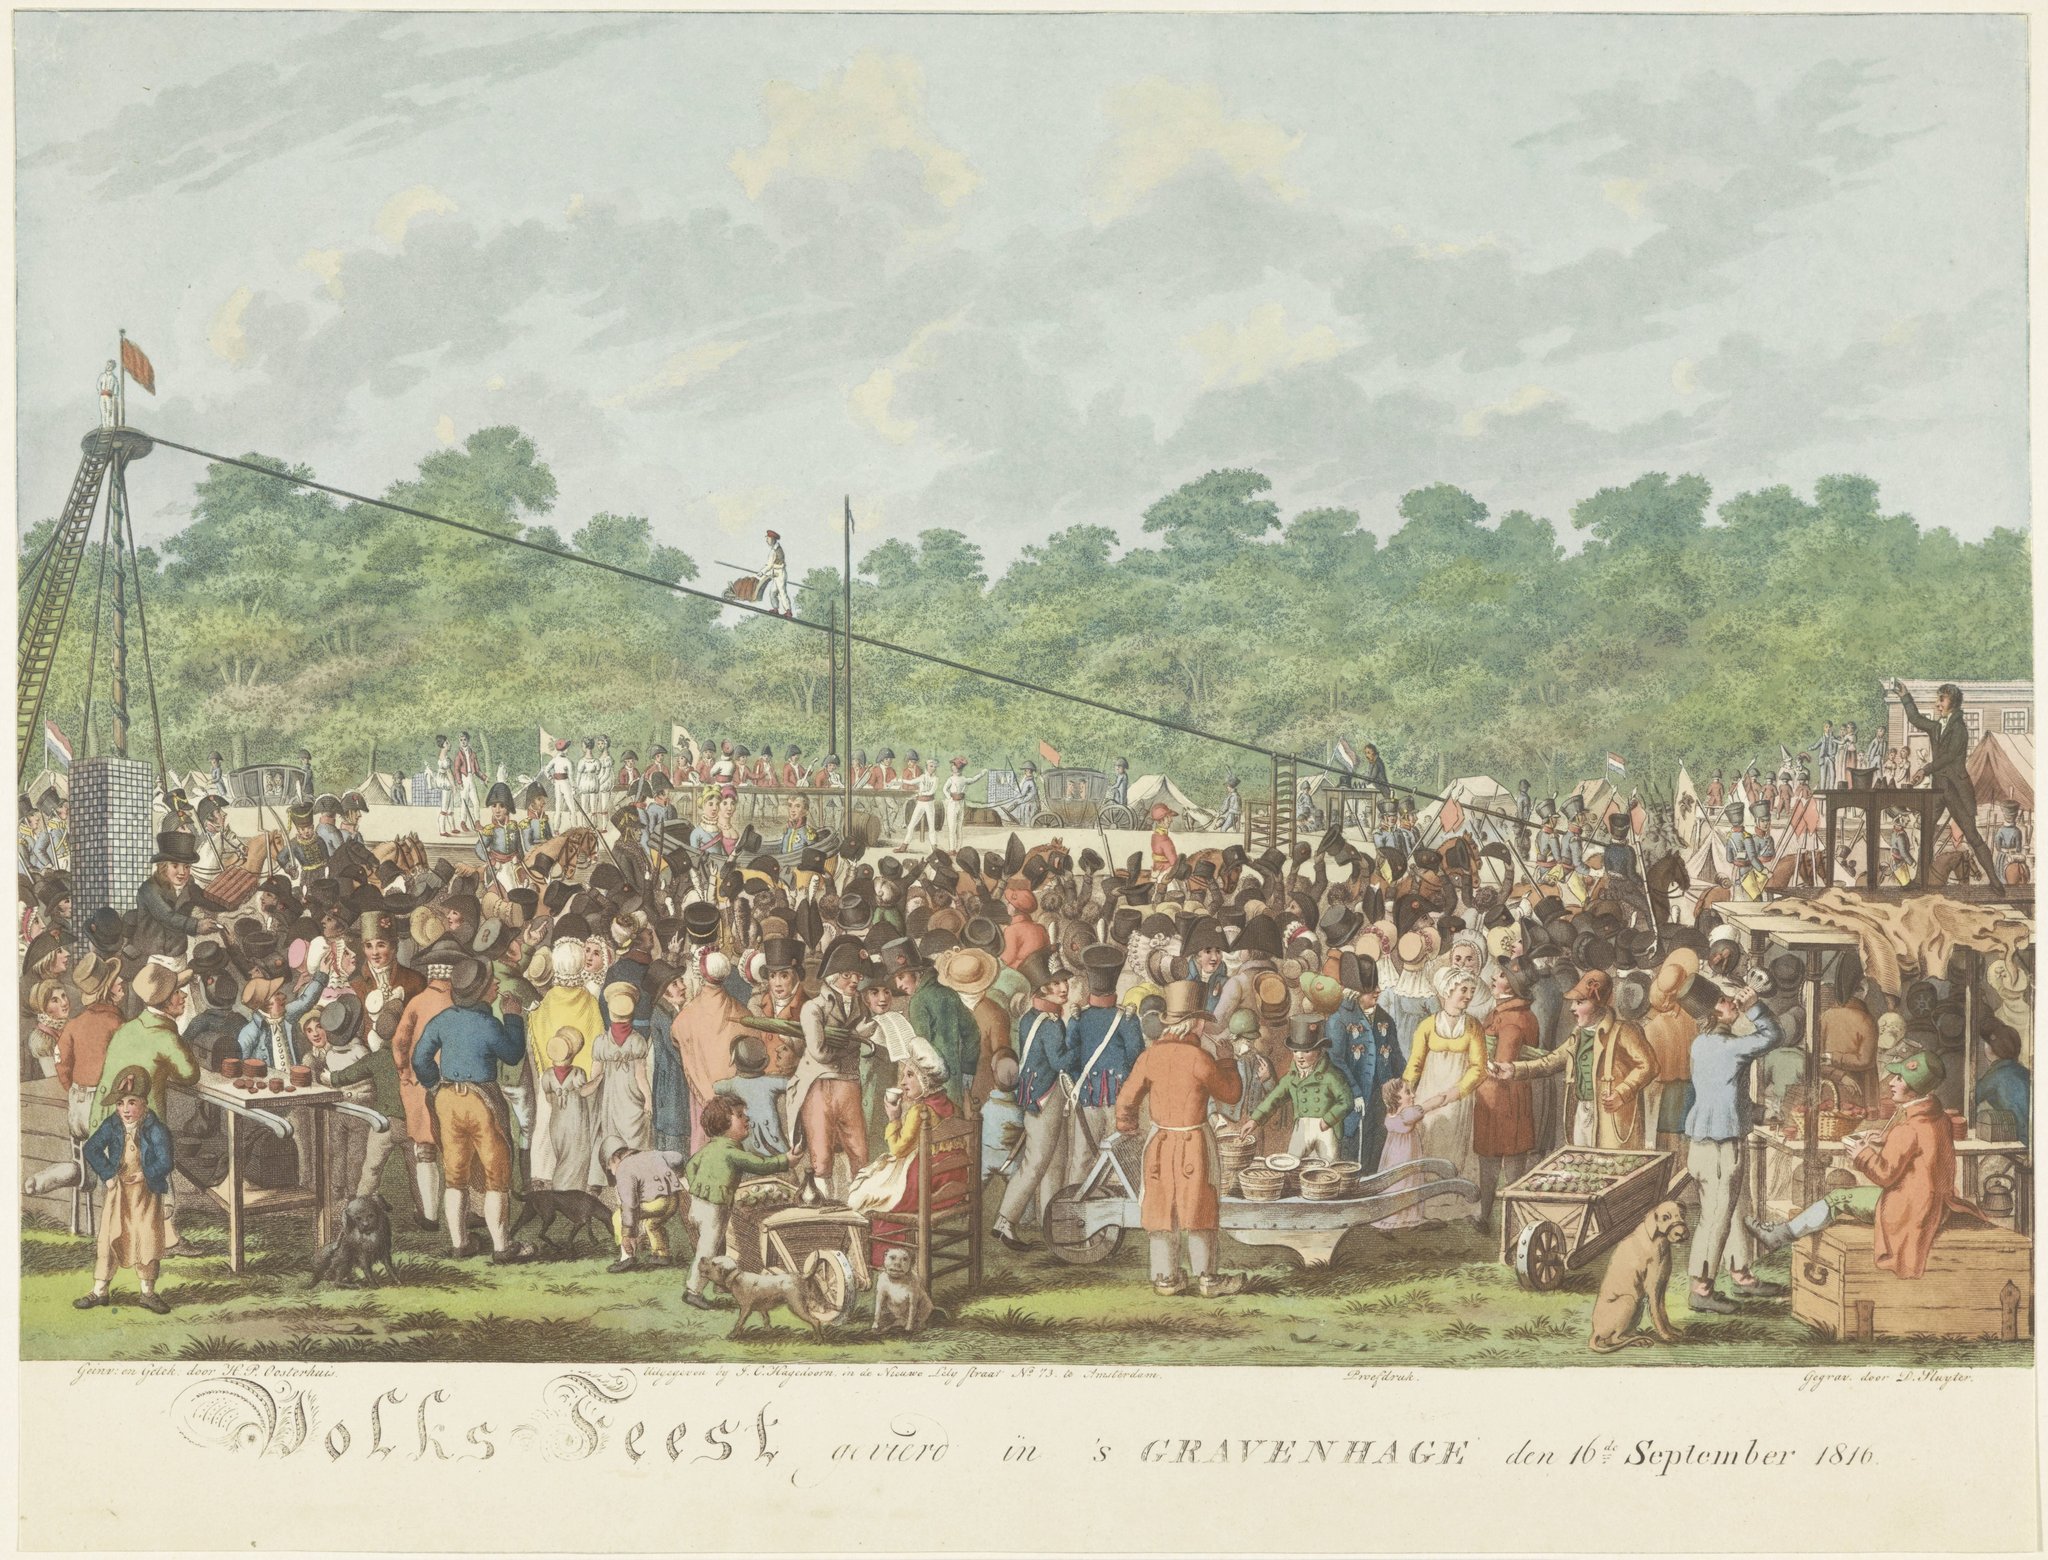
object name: print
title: Volks Feest gevierd in 's Gravenhage den 16de September 1816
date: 1816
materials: paper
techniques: aquatint, etching, hand coloring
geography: amsterdam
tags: anna paulowna romanowa, william ii of the netherlands, public festivities at other royal events, not meant or mentioned above, fancy fair, performance in the open air (pleasure fair), tight-ropewalker, the hague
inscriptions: collector's mark: Lugt 2228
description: Volksfeest op het Malieveld te Den Haag ter ere van de komst van de prins en prinses van Oranje naar Den Haag op 16 september 1816. Een grote menigte vermaakt zich met allerlei spellen en voorstellingen: koorddansen, goochelen, toneel, muziek etc. Op de voorgrond straatverkopers met karren waaruit eten en drinken wordt verkocht. Links van het midden de aankomst van het open rijtuig met de prins en prinses.